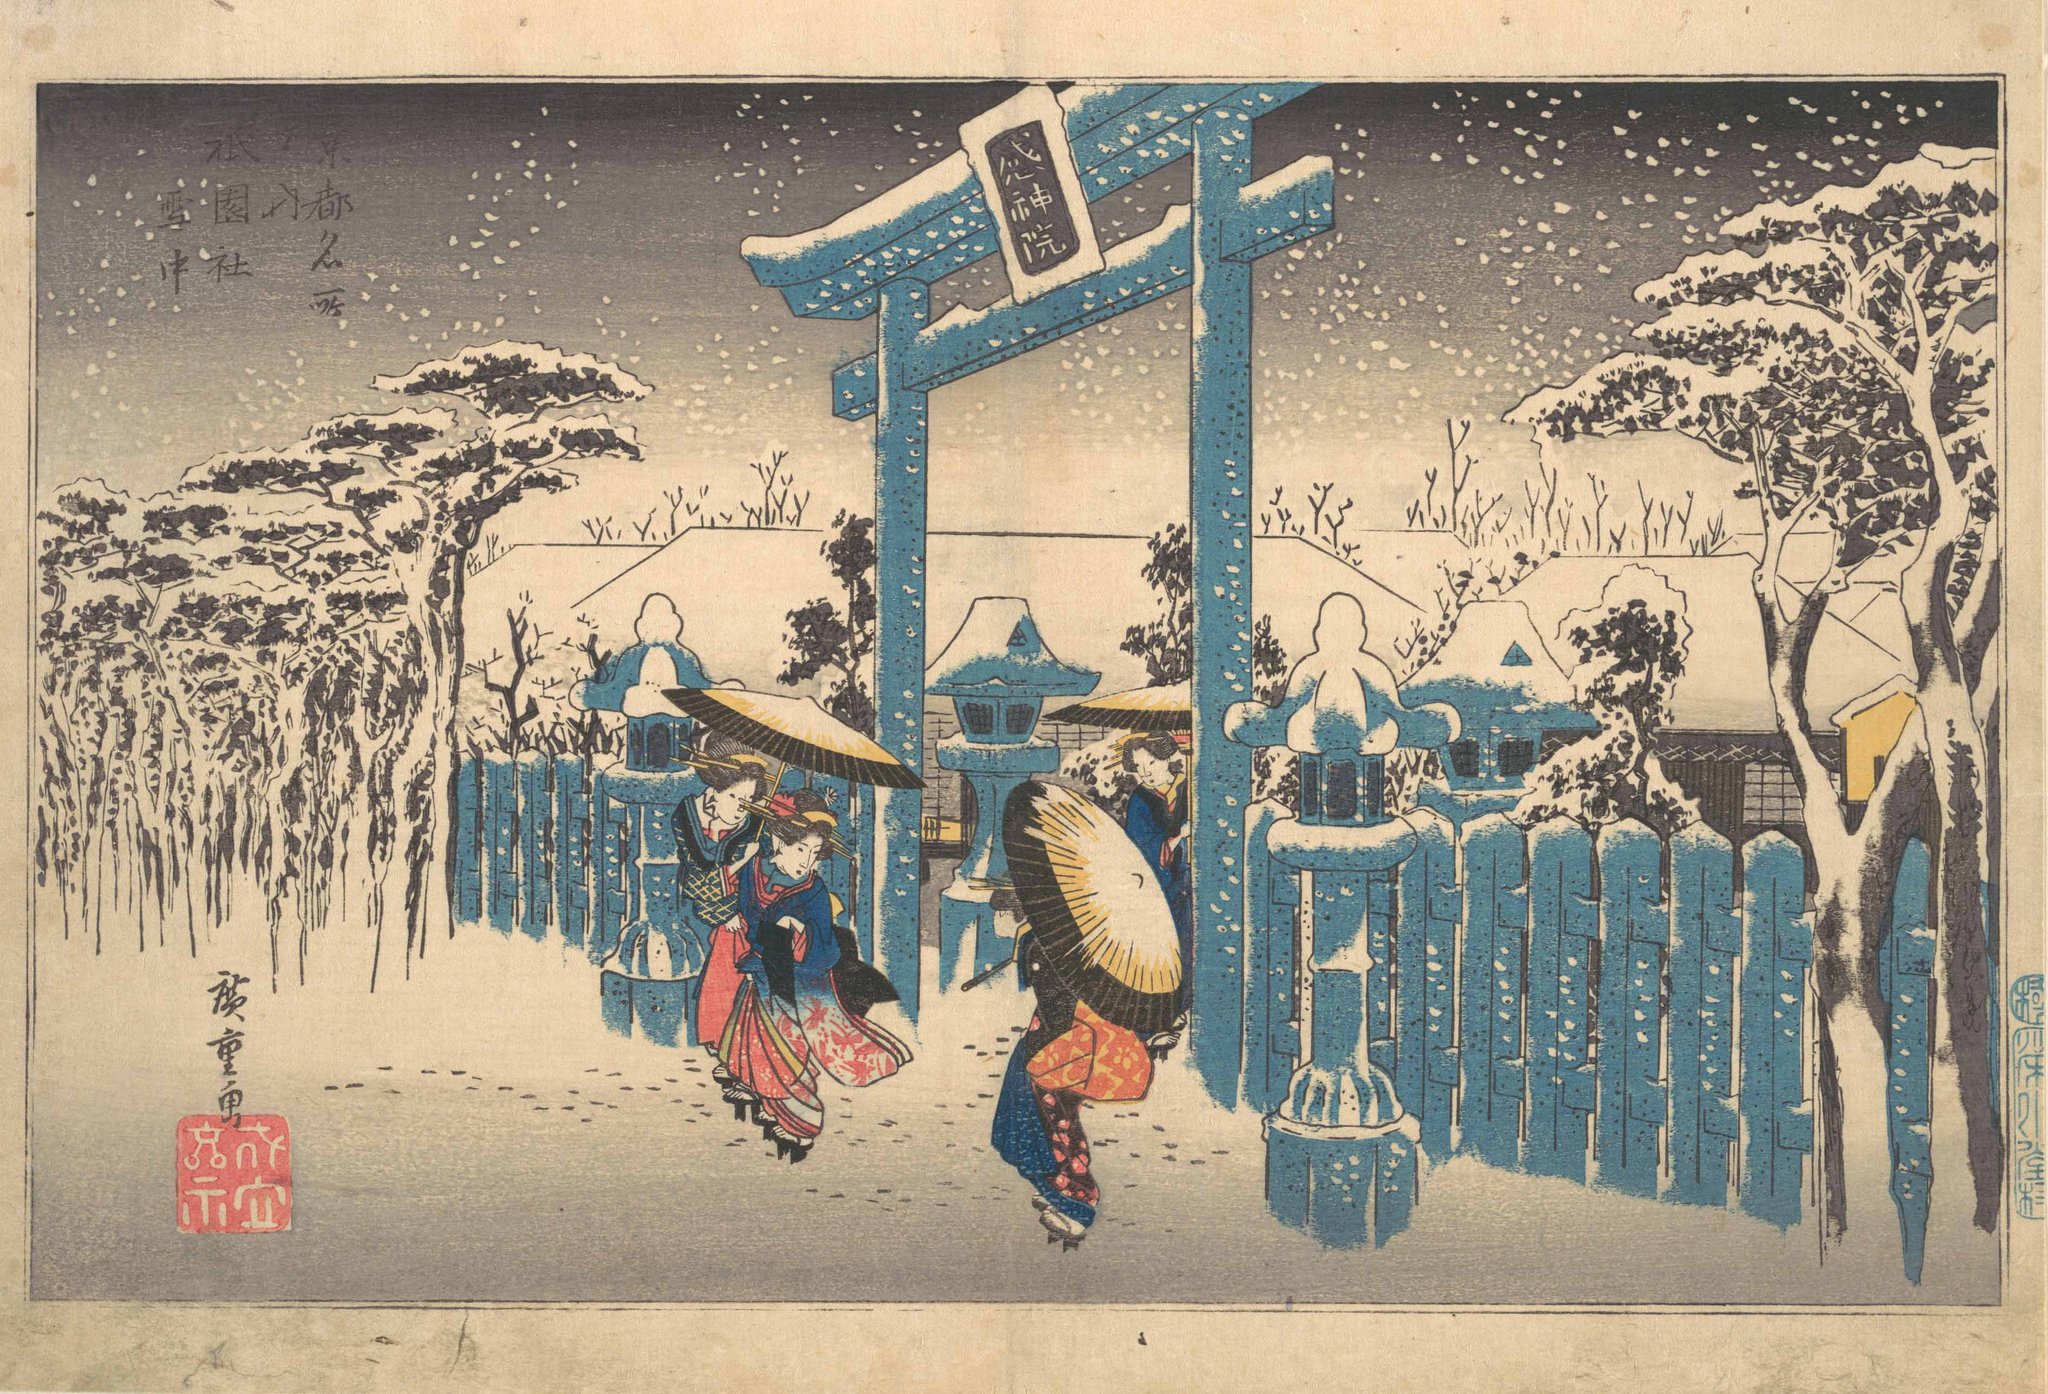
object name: print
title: The Gion Shrine in Snow, from the series Famous Views of Kyoto (Kyōto meisho no uchi)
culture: japanese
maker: utagawa hiroshige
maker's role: artist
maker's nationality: japanese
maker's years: 1797-1858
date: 1834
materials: ink, paper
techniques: woodblock print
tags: gates,women,winter,snow